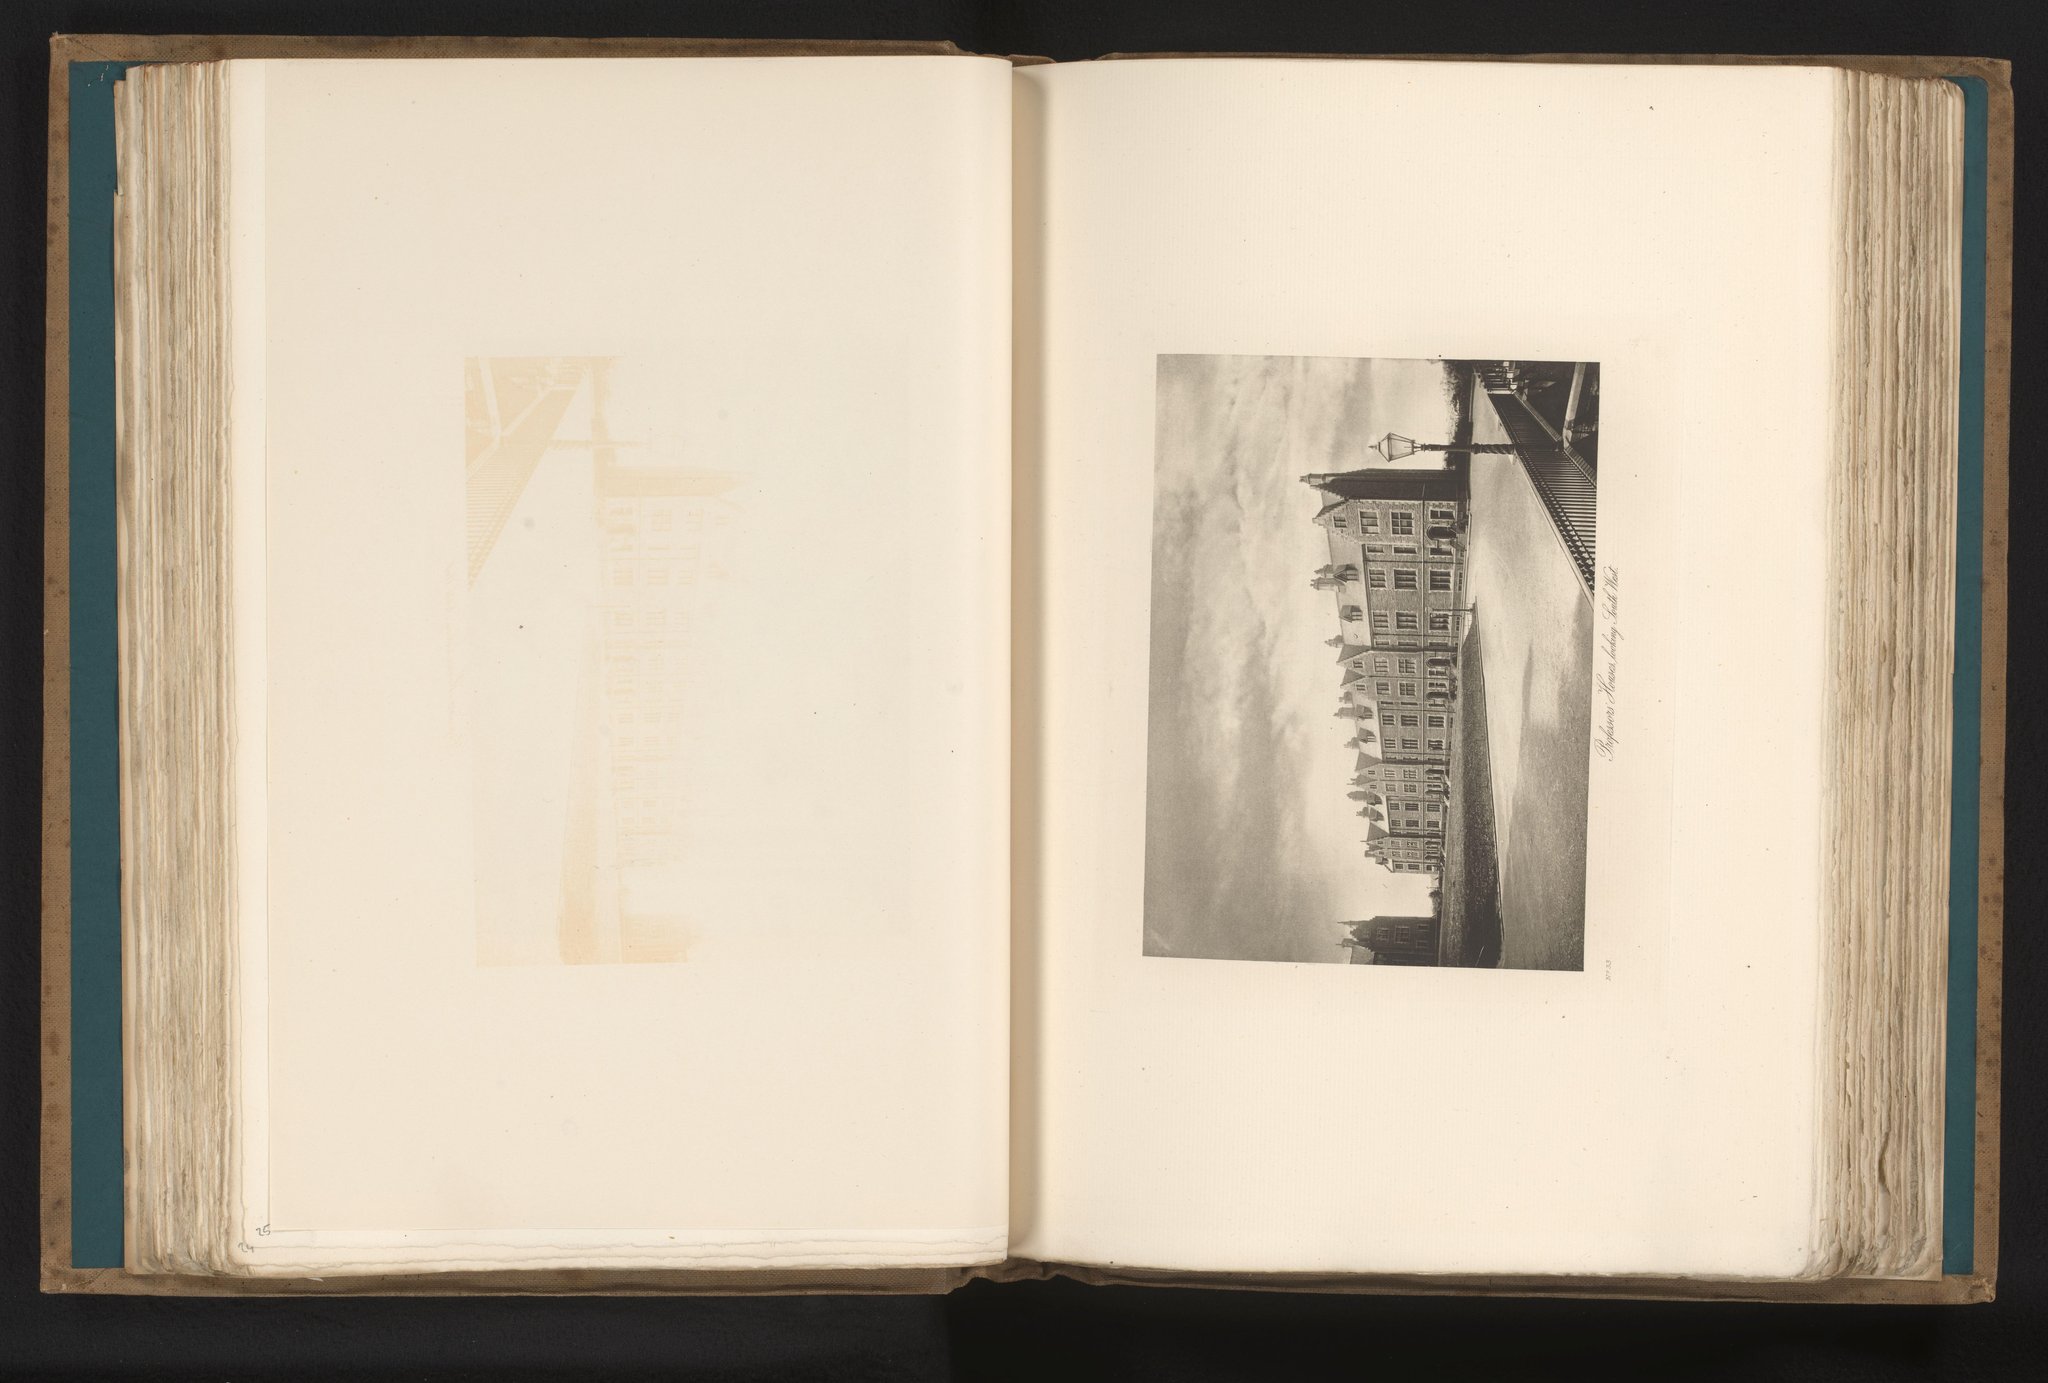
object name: photomechanical print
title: Professors' Houses, looking South West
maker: Anonymous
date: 1886-1891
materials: paper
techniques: photoaquatint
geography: glasgow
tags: university (+ building ~ education, tuition), housing, glasgow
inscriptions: inscription: ‘No.33’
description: Prent op tweeëndertigste ongenummerde pagina na pagina xxxiii.